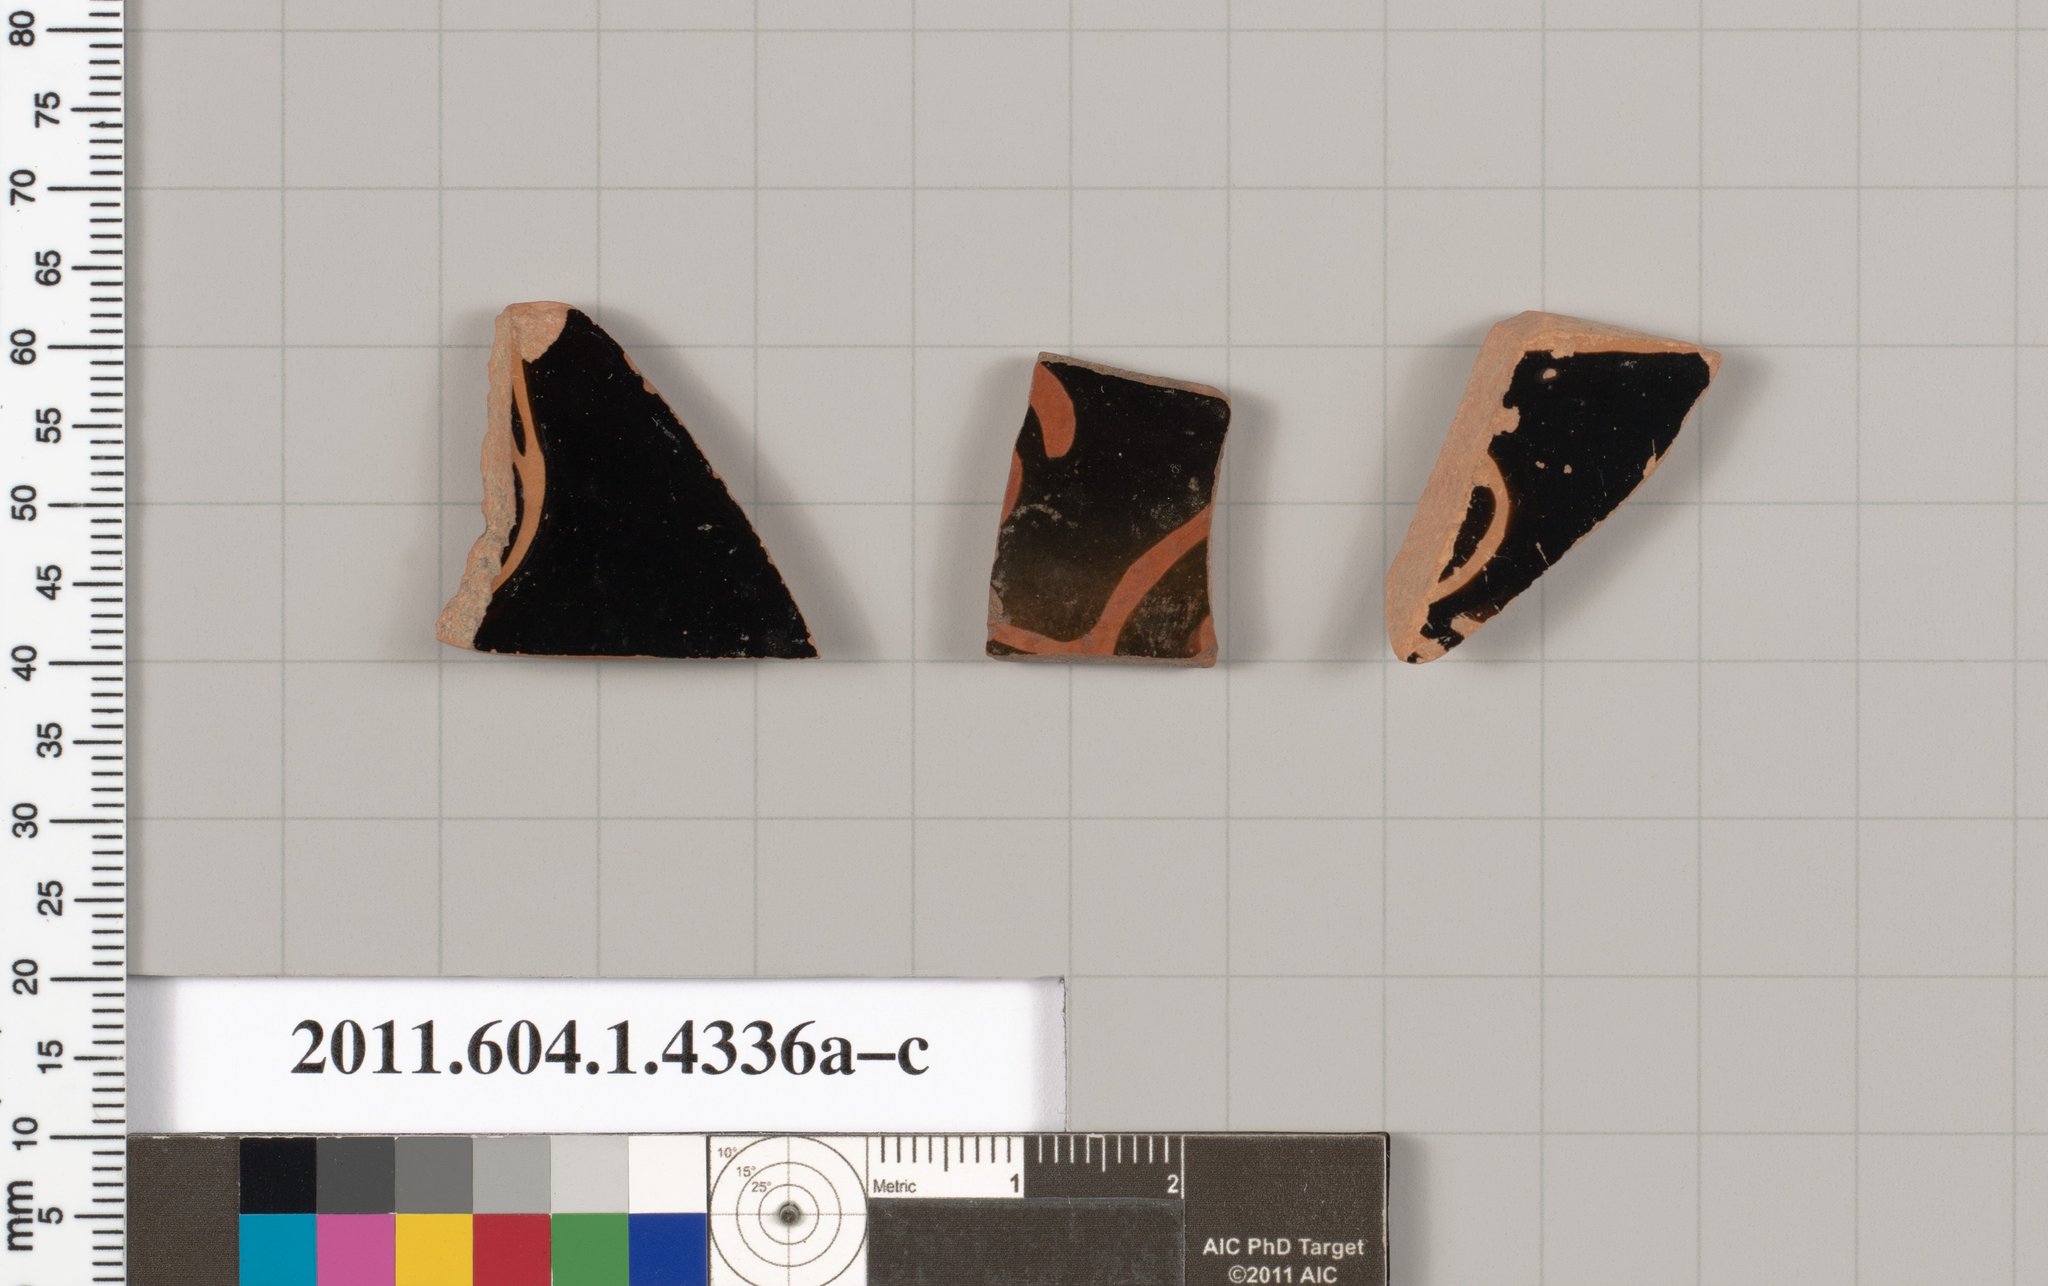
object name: kylix fragment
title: Terracotta fragments of kylikes (drinking cups)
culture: greek, attic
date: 500-451 BCE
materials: terracotta